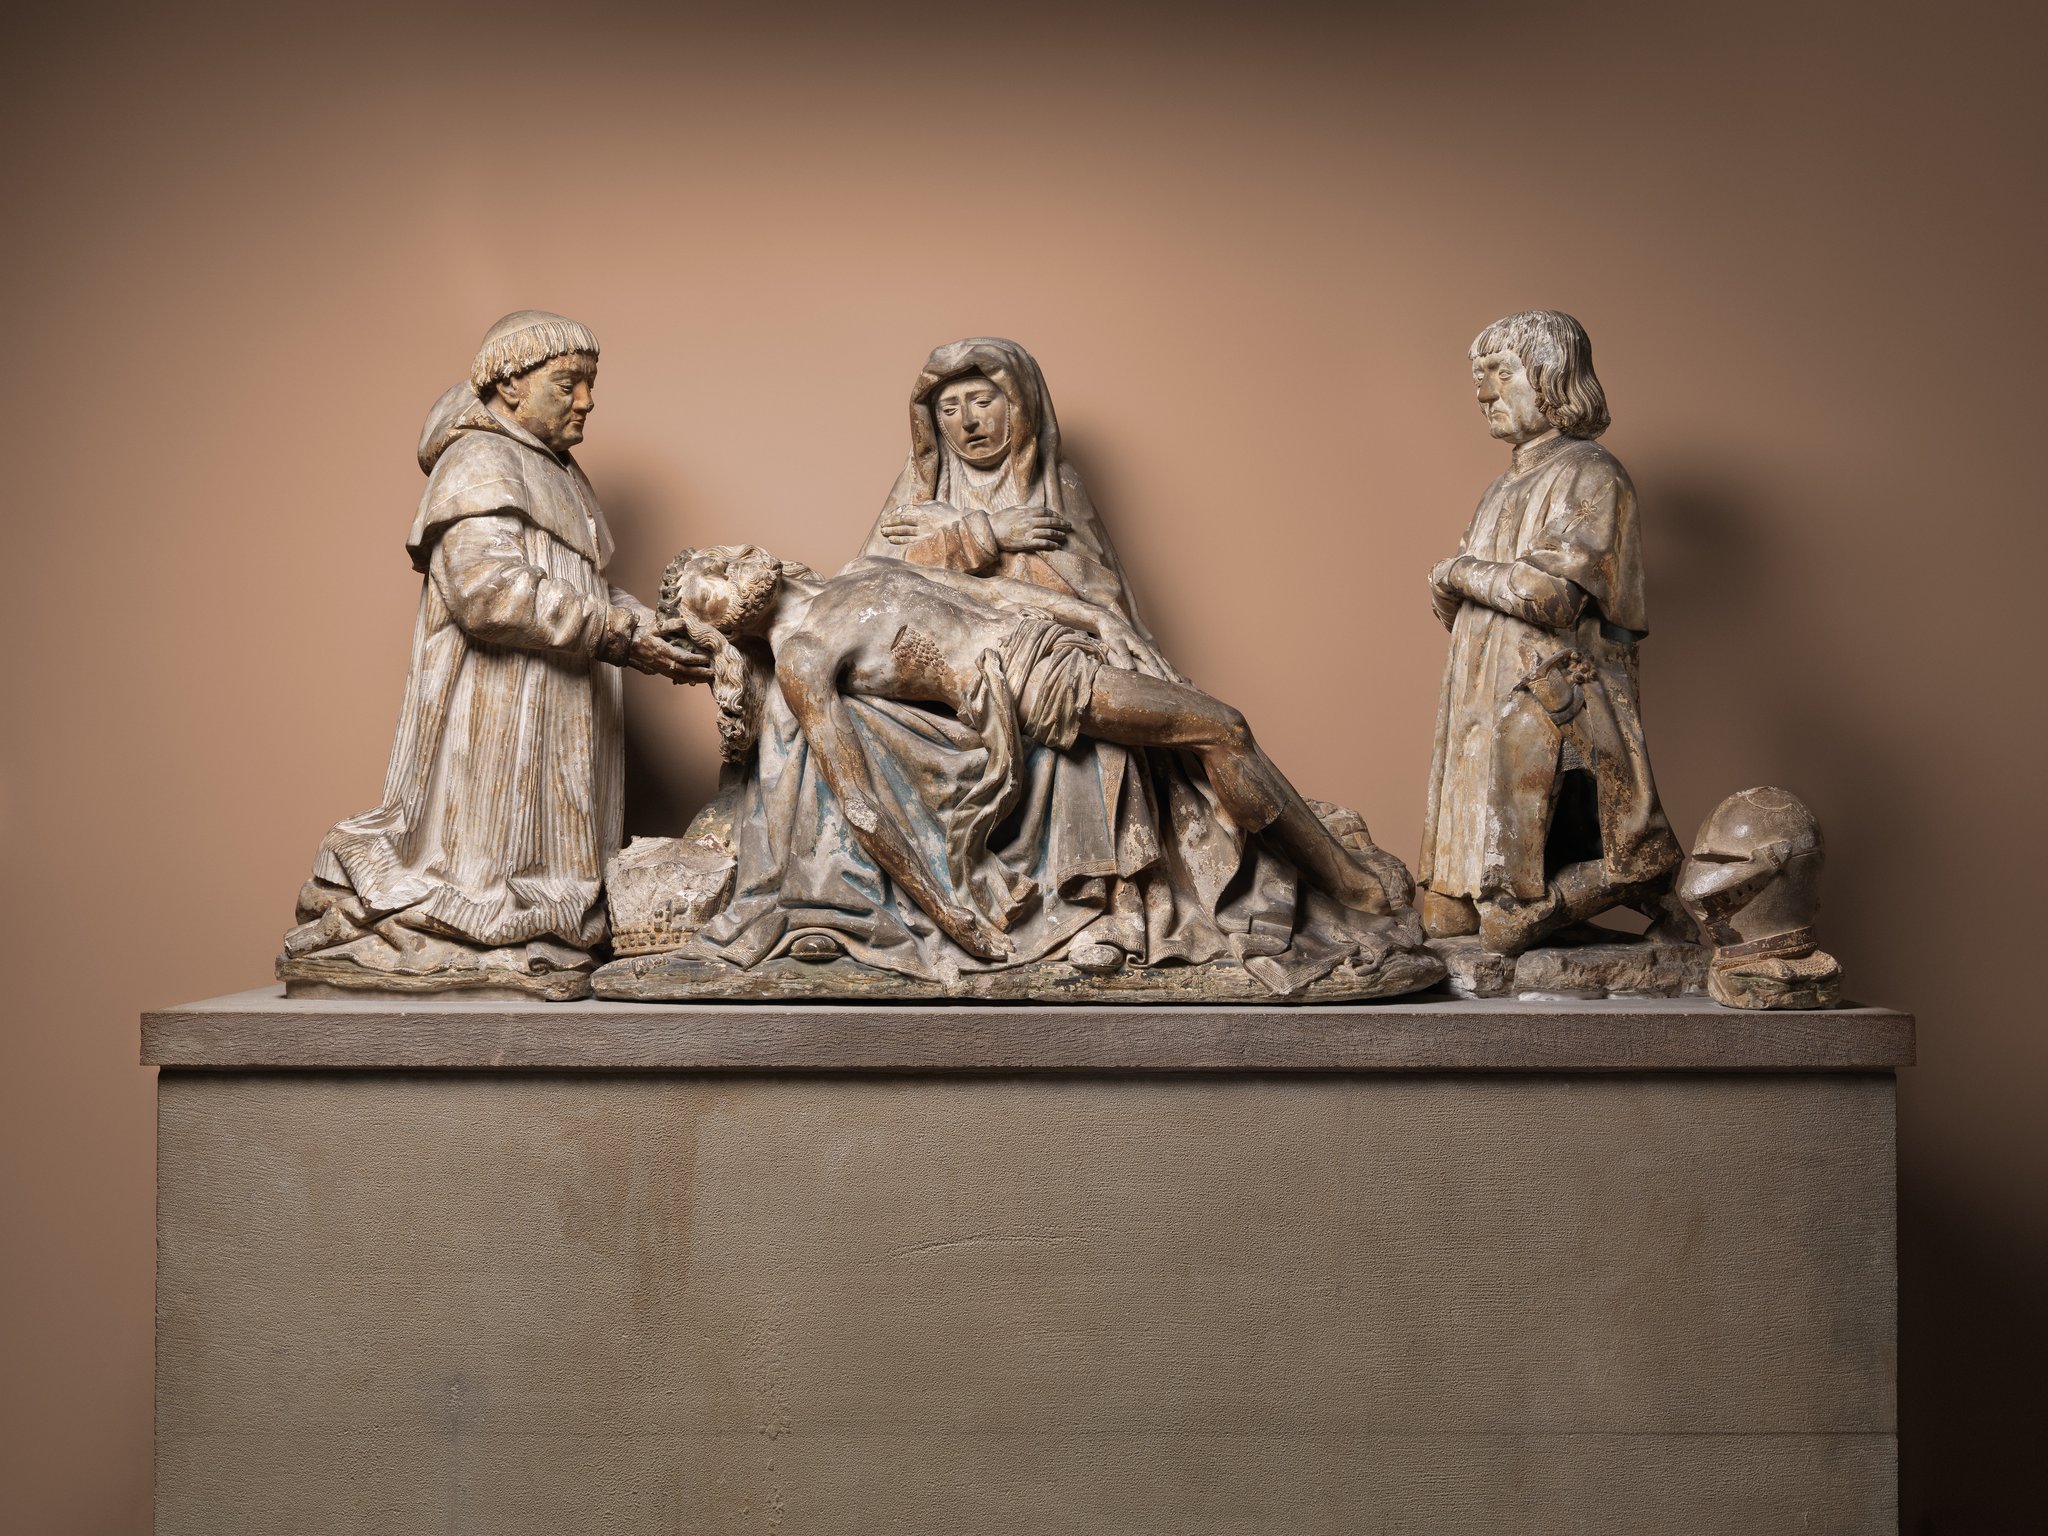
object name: sculpture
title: Pietà with Donors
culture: french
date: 1515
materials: limestone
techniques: polychromy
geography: france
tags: men,christ,virgin mary